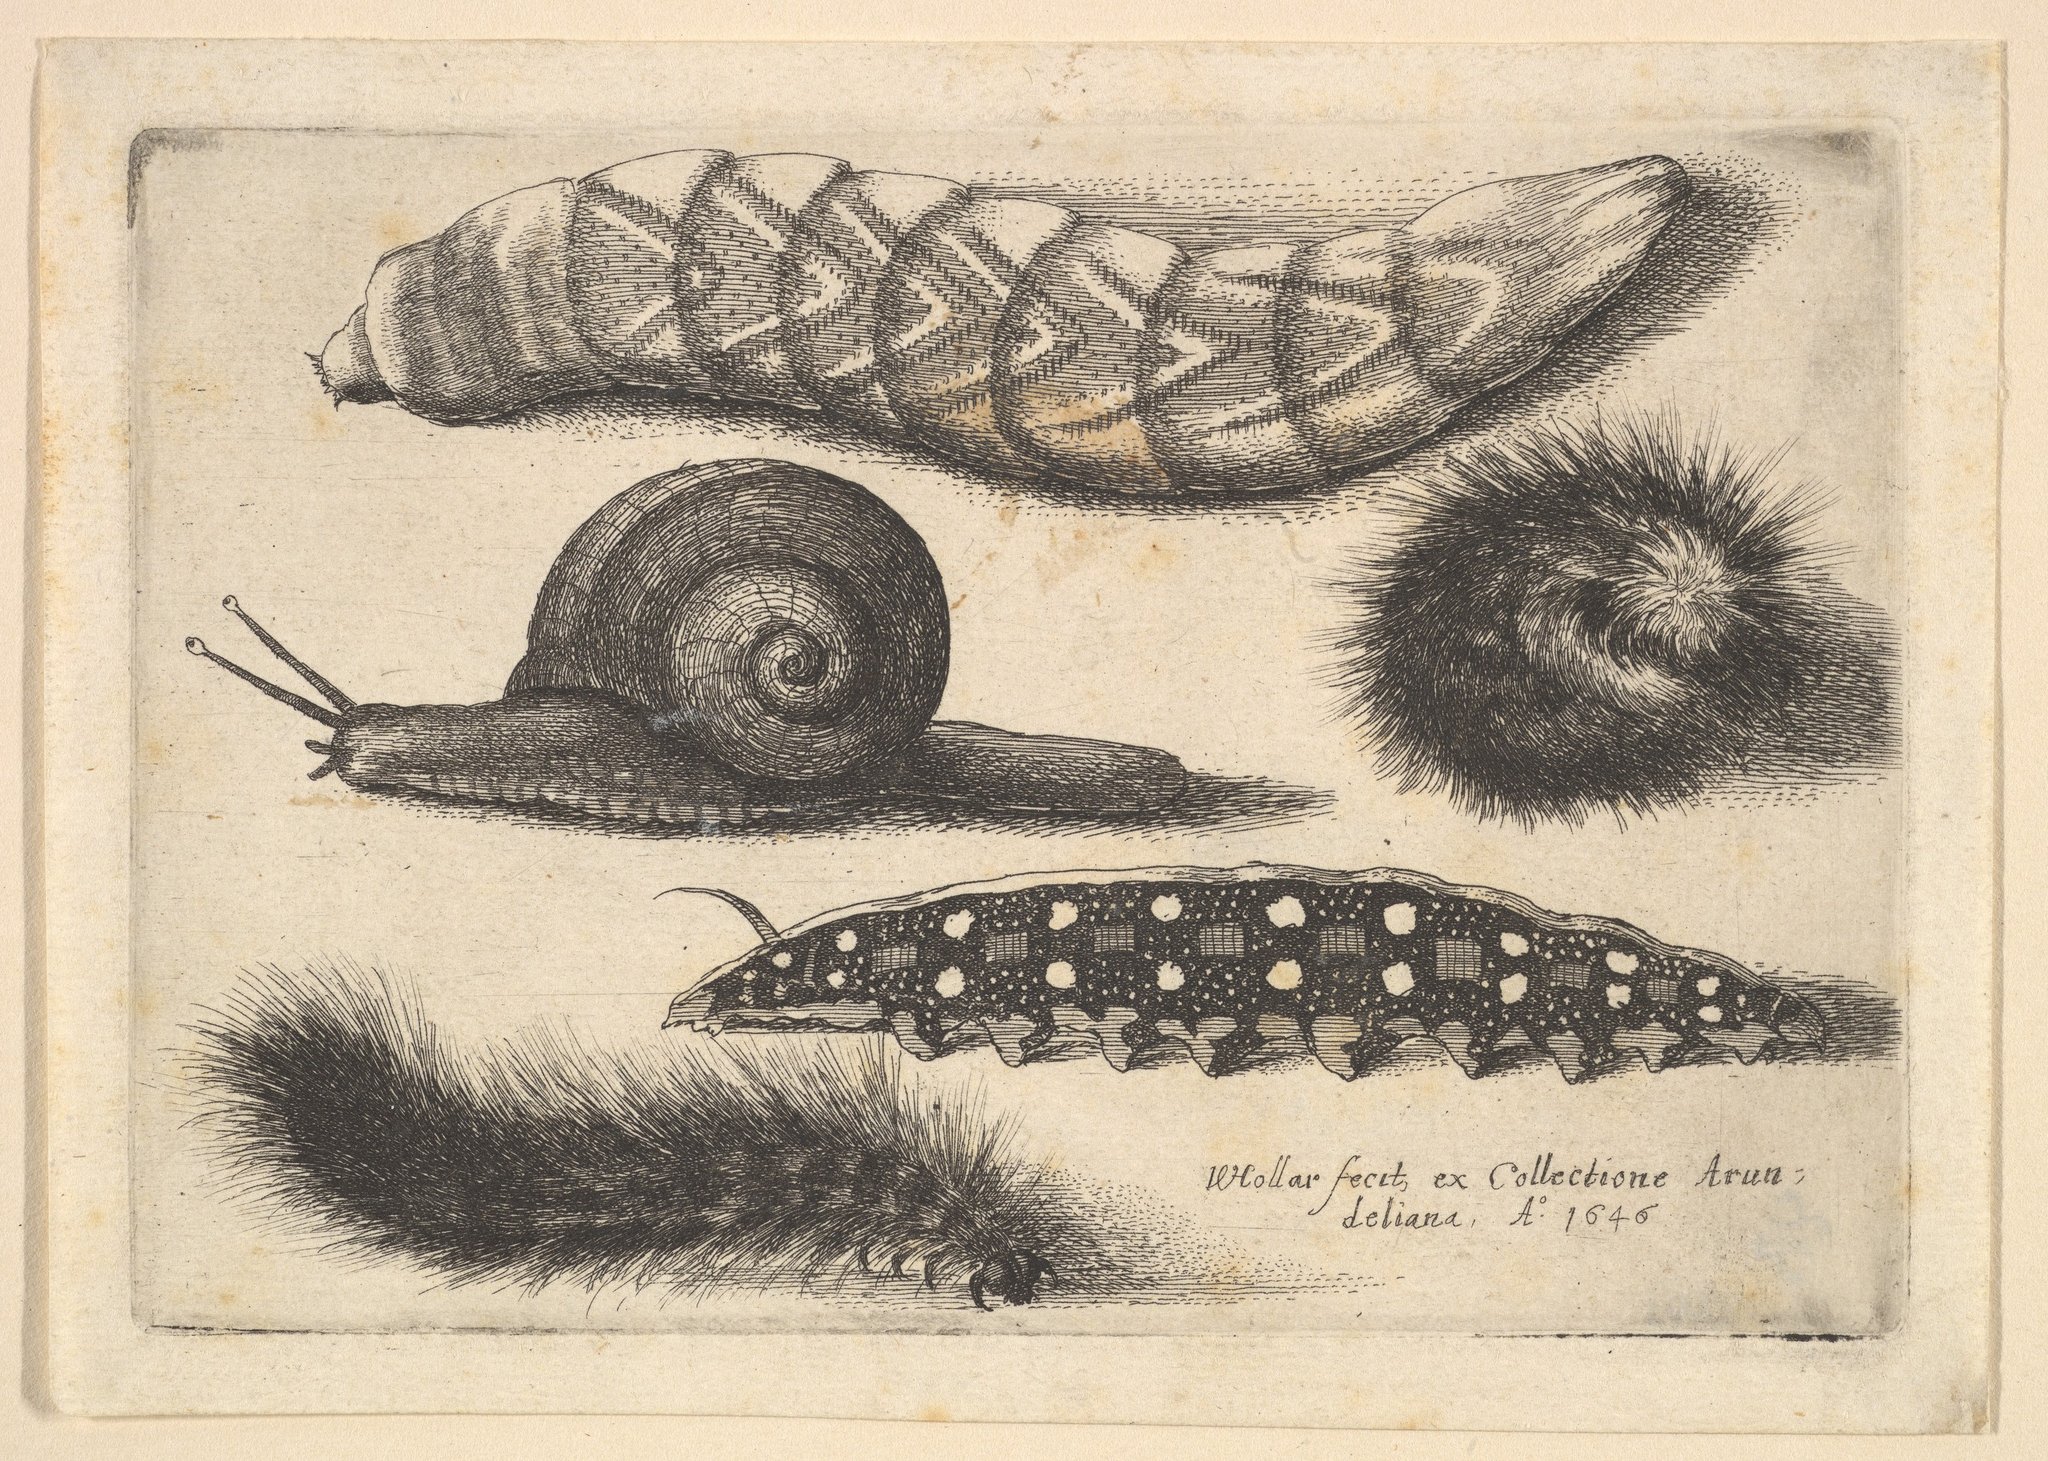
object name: print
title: Four Caterpillars and a Snail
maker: wenceslaus hollar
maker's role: artist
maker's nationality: bohemian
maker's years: 1607-1677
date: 1646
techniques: etching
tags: insects,snails